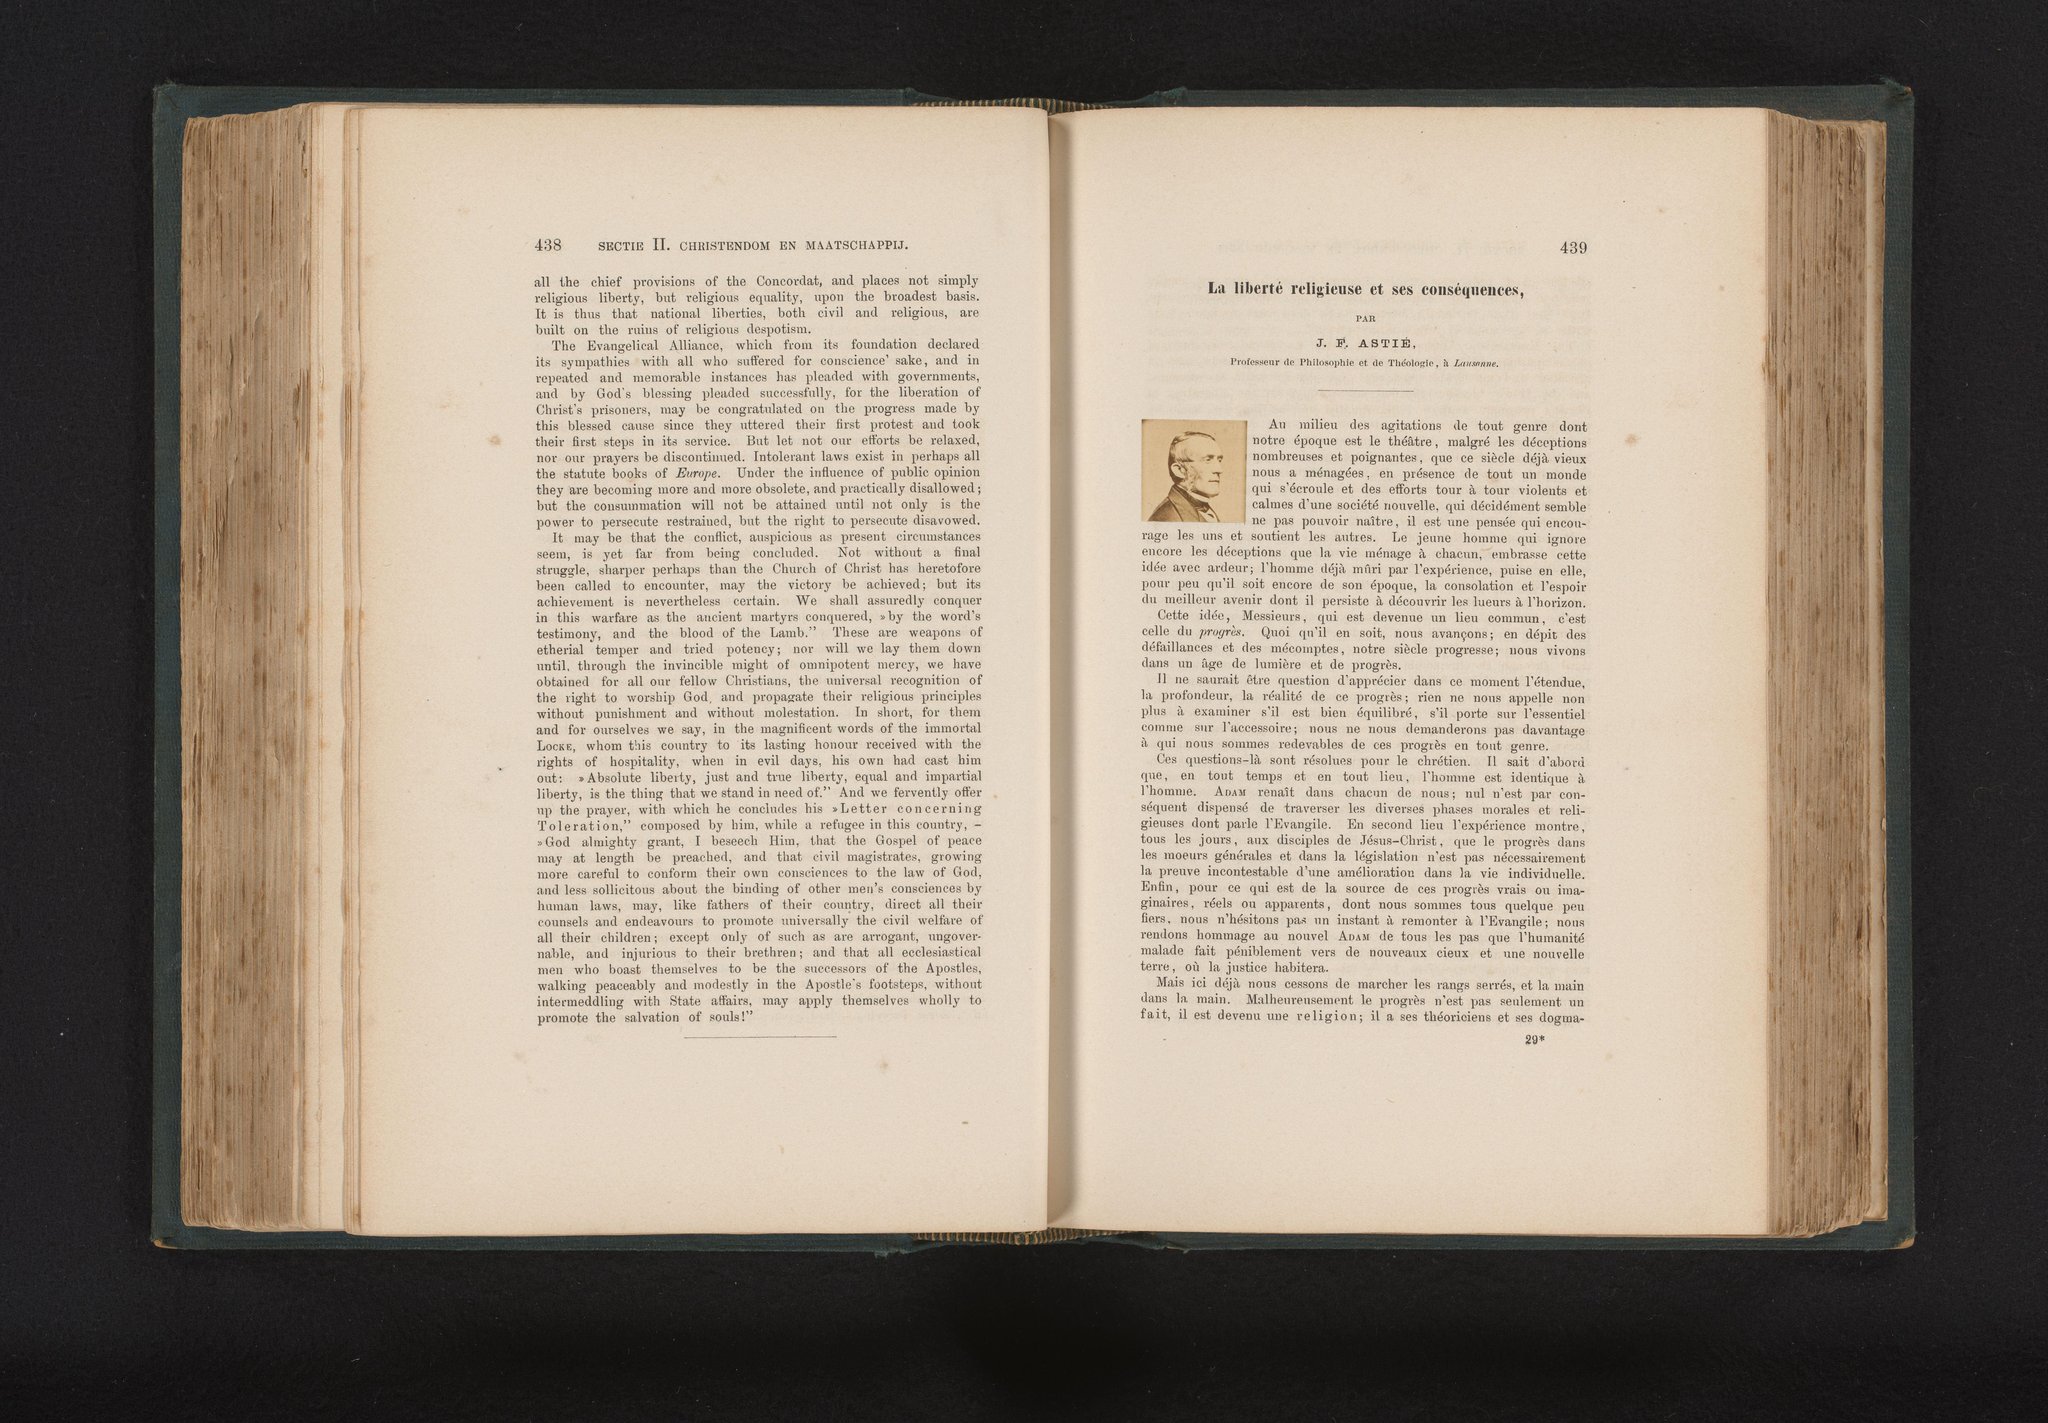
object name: page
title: Portret van J.F. Astié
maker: Anonymous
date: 1855-1867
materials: paper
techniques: albumen print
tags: historical persons